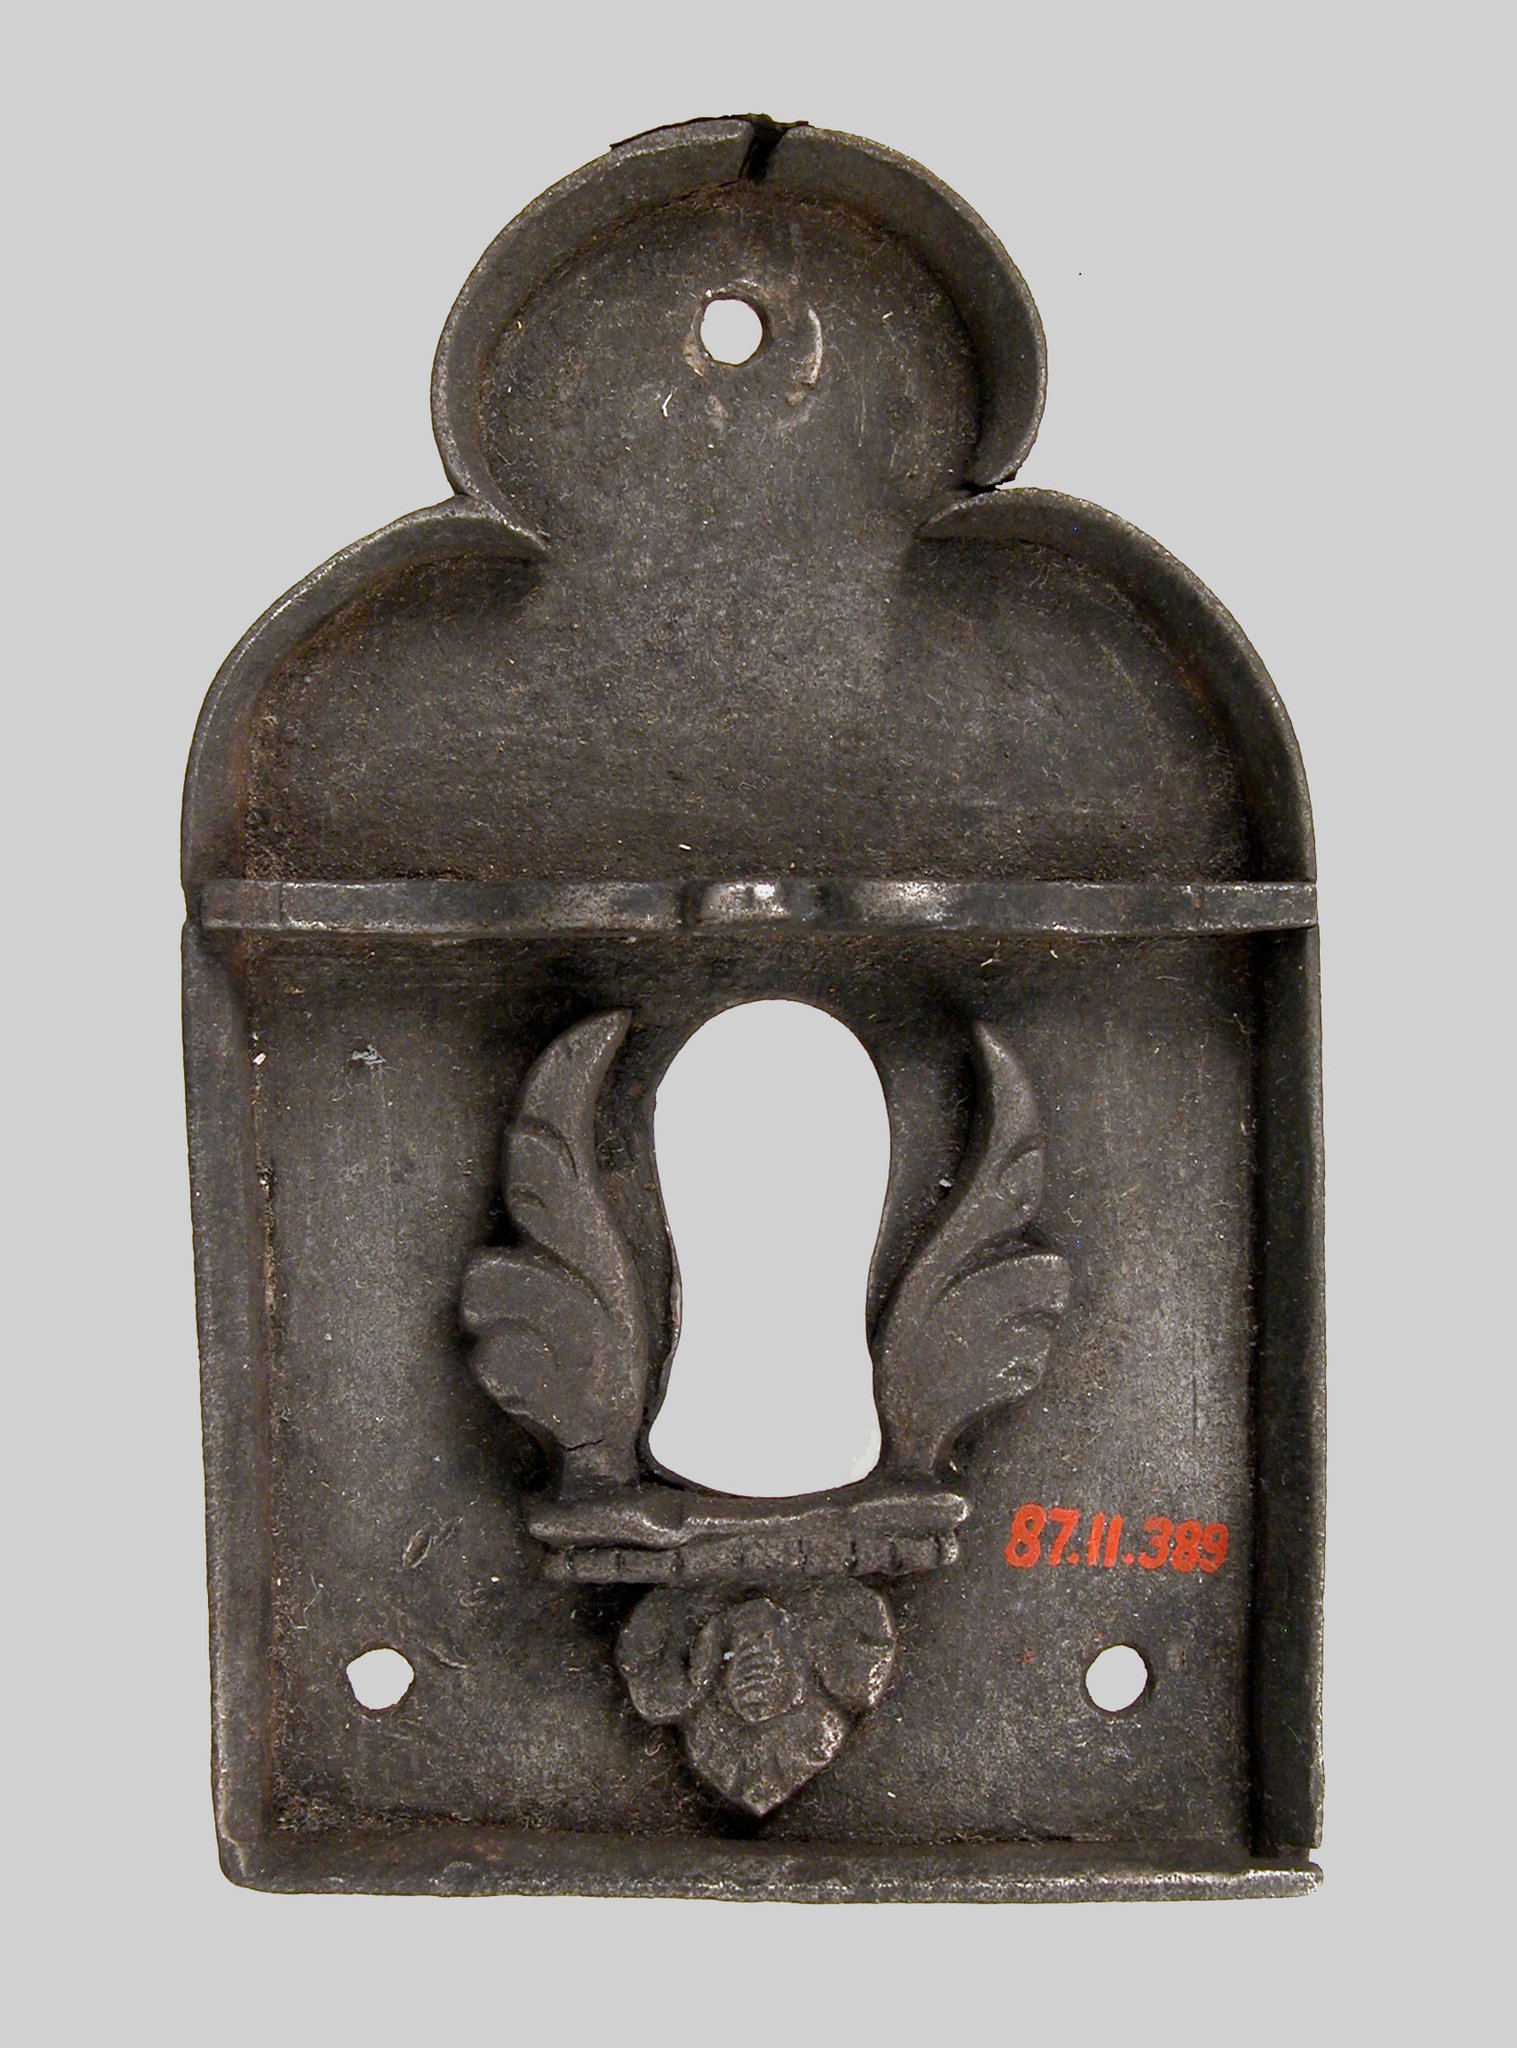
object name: escutcheon plate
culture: european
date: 1401-1500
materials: iron